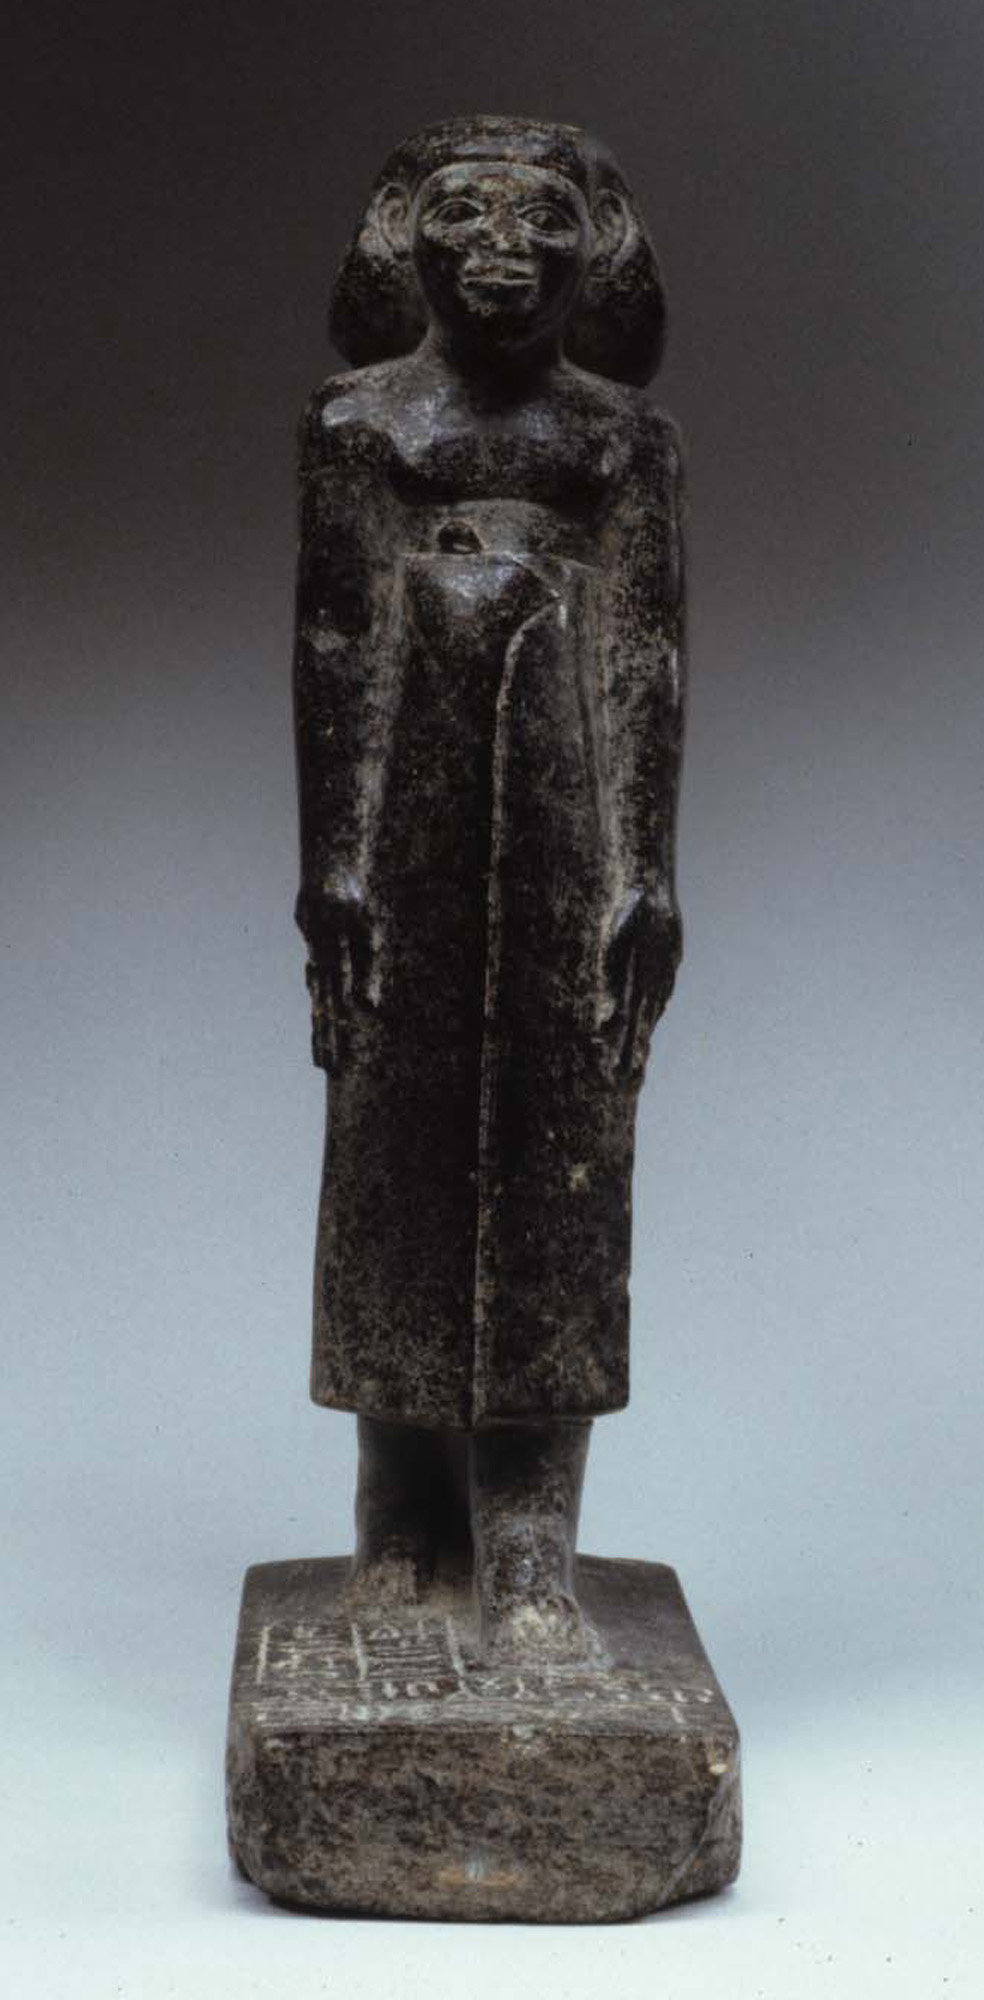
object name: statuette, striding man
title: Statuette of Imenytirry in long kilt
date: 1802-1640 BCE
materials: stone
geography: egypt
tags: human figures